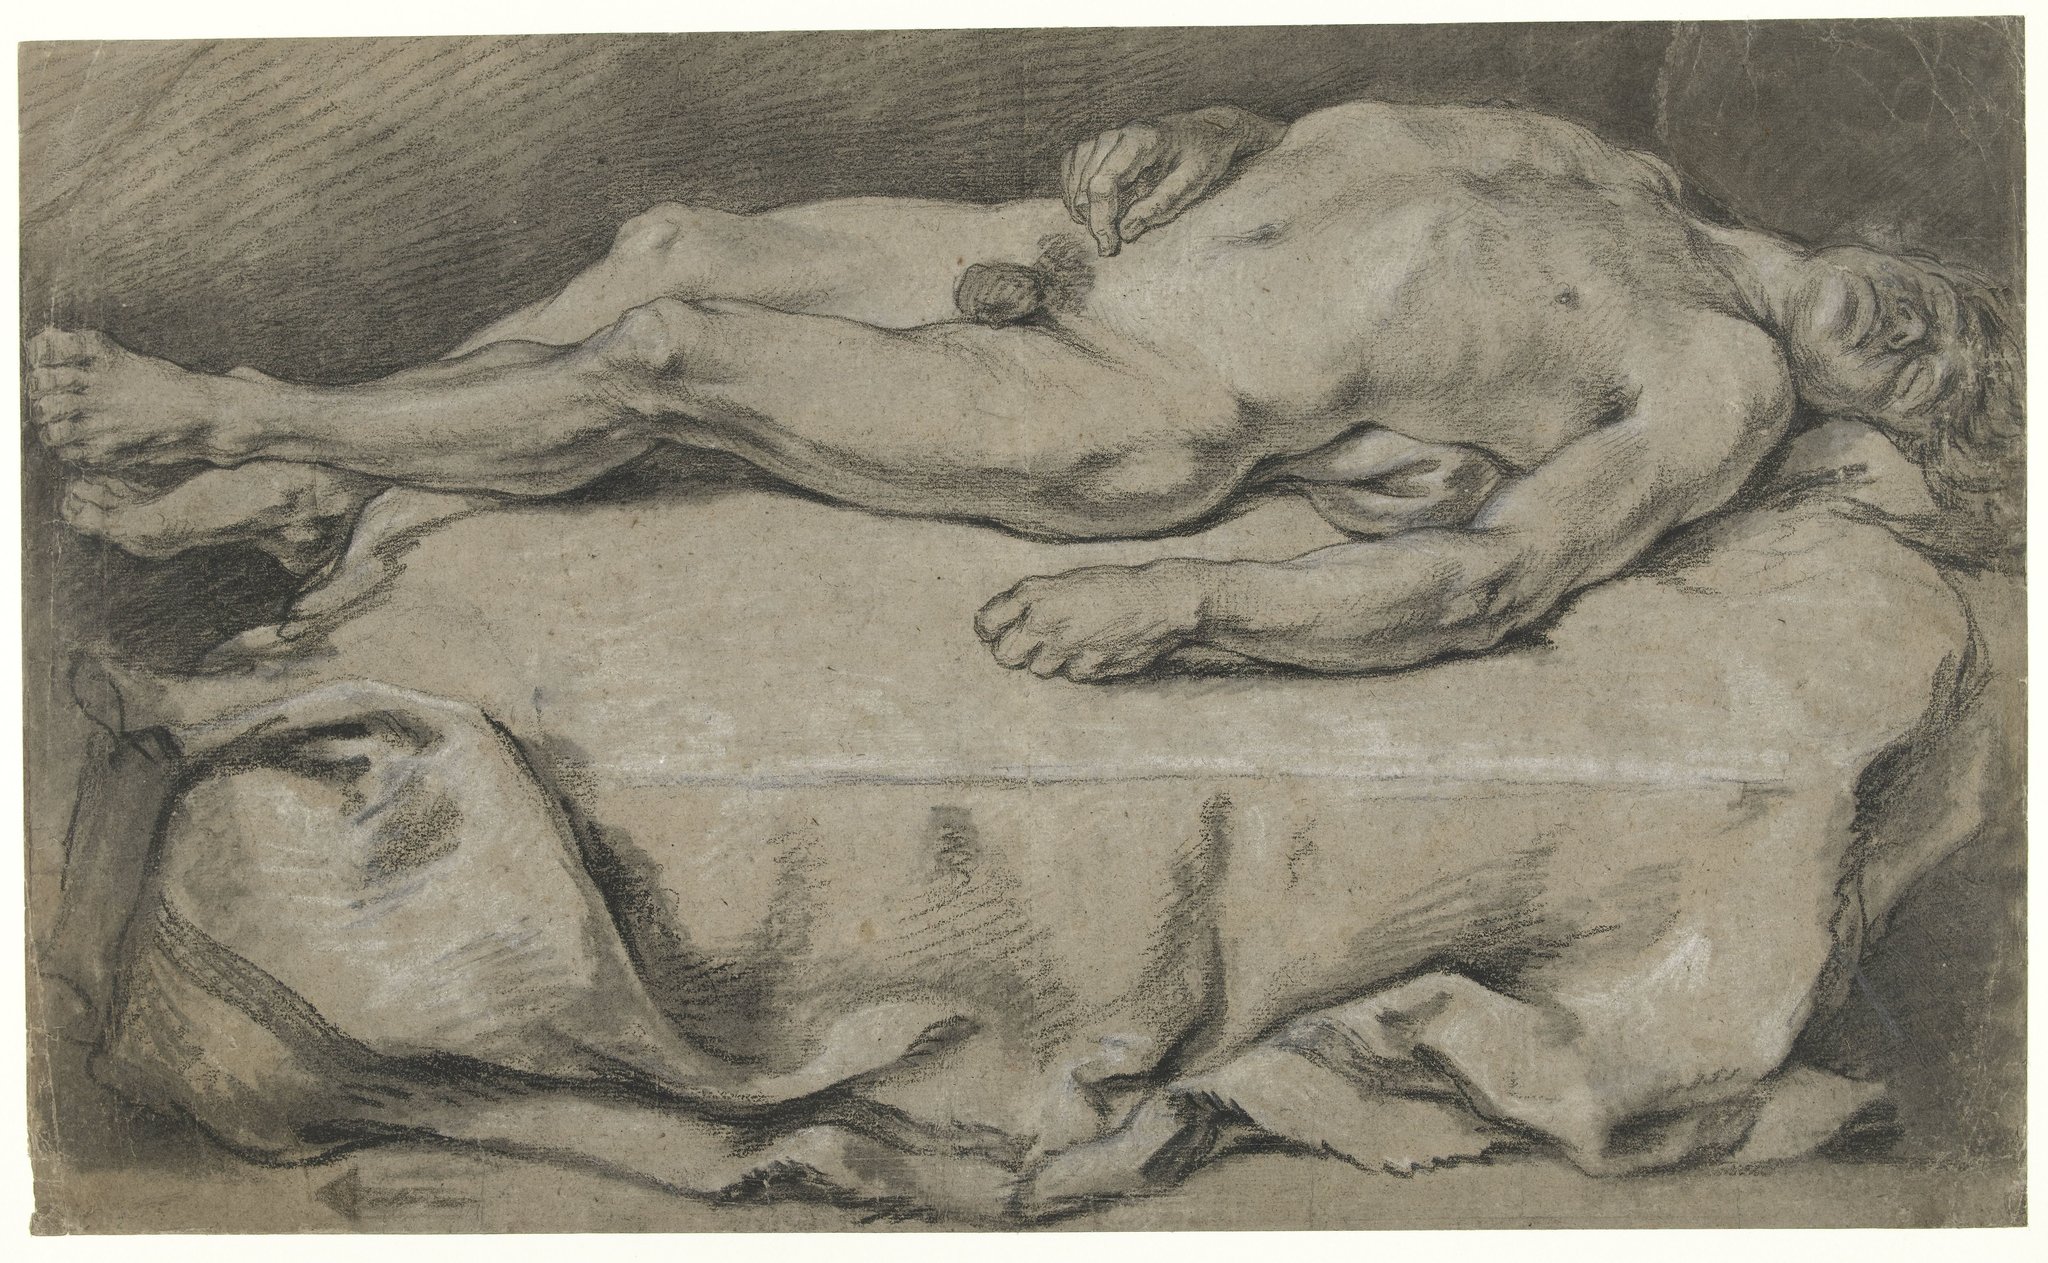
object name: drawing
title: Anatomische studie van liggend mannelijk naakt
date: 1720-1765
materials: chalk, paper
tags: lying figure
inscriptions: collector's mark, verso, lower centre: Lugt 2228, number, verso, upper left, purple ink: ‘171’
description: Liggend mannelijk naakt op een lage rustbank met een gedrapeerd kleed.